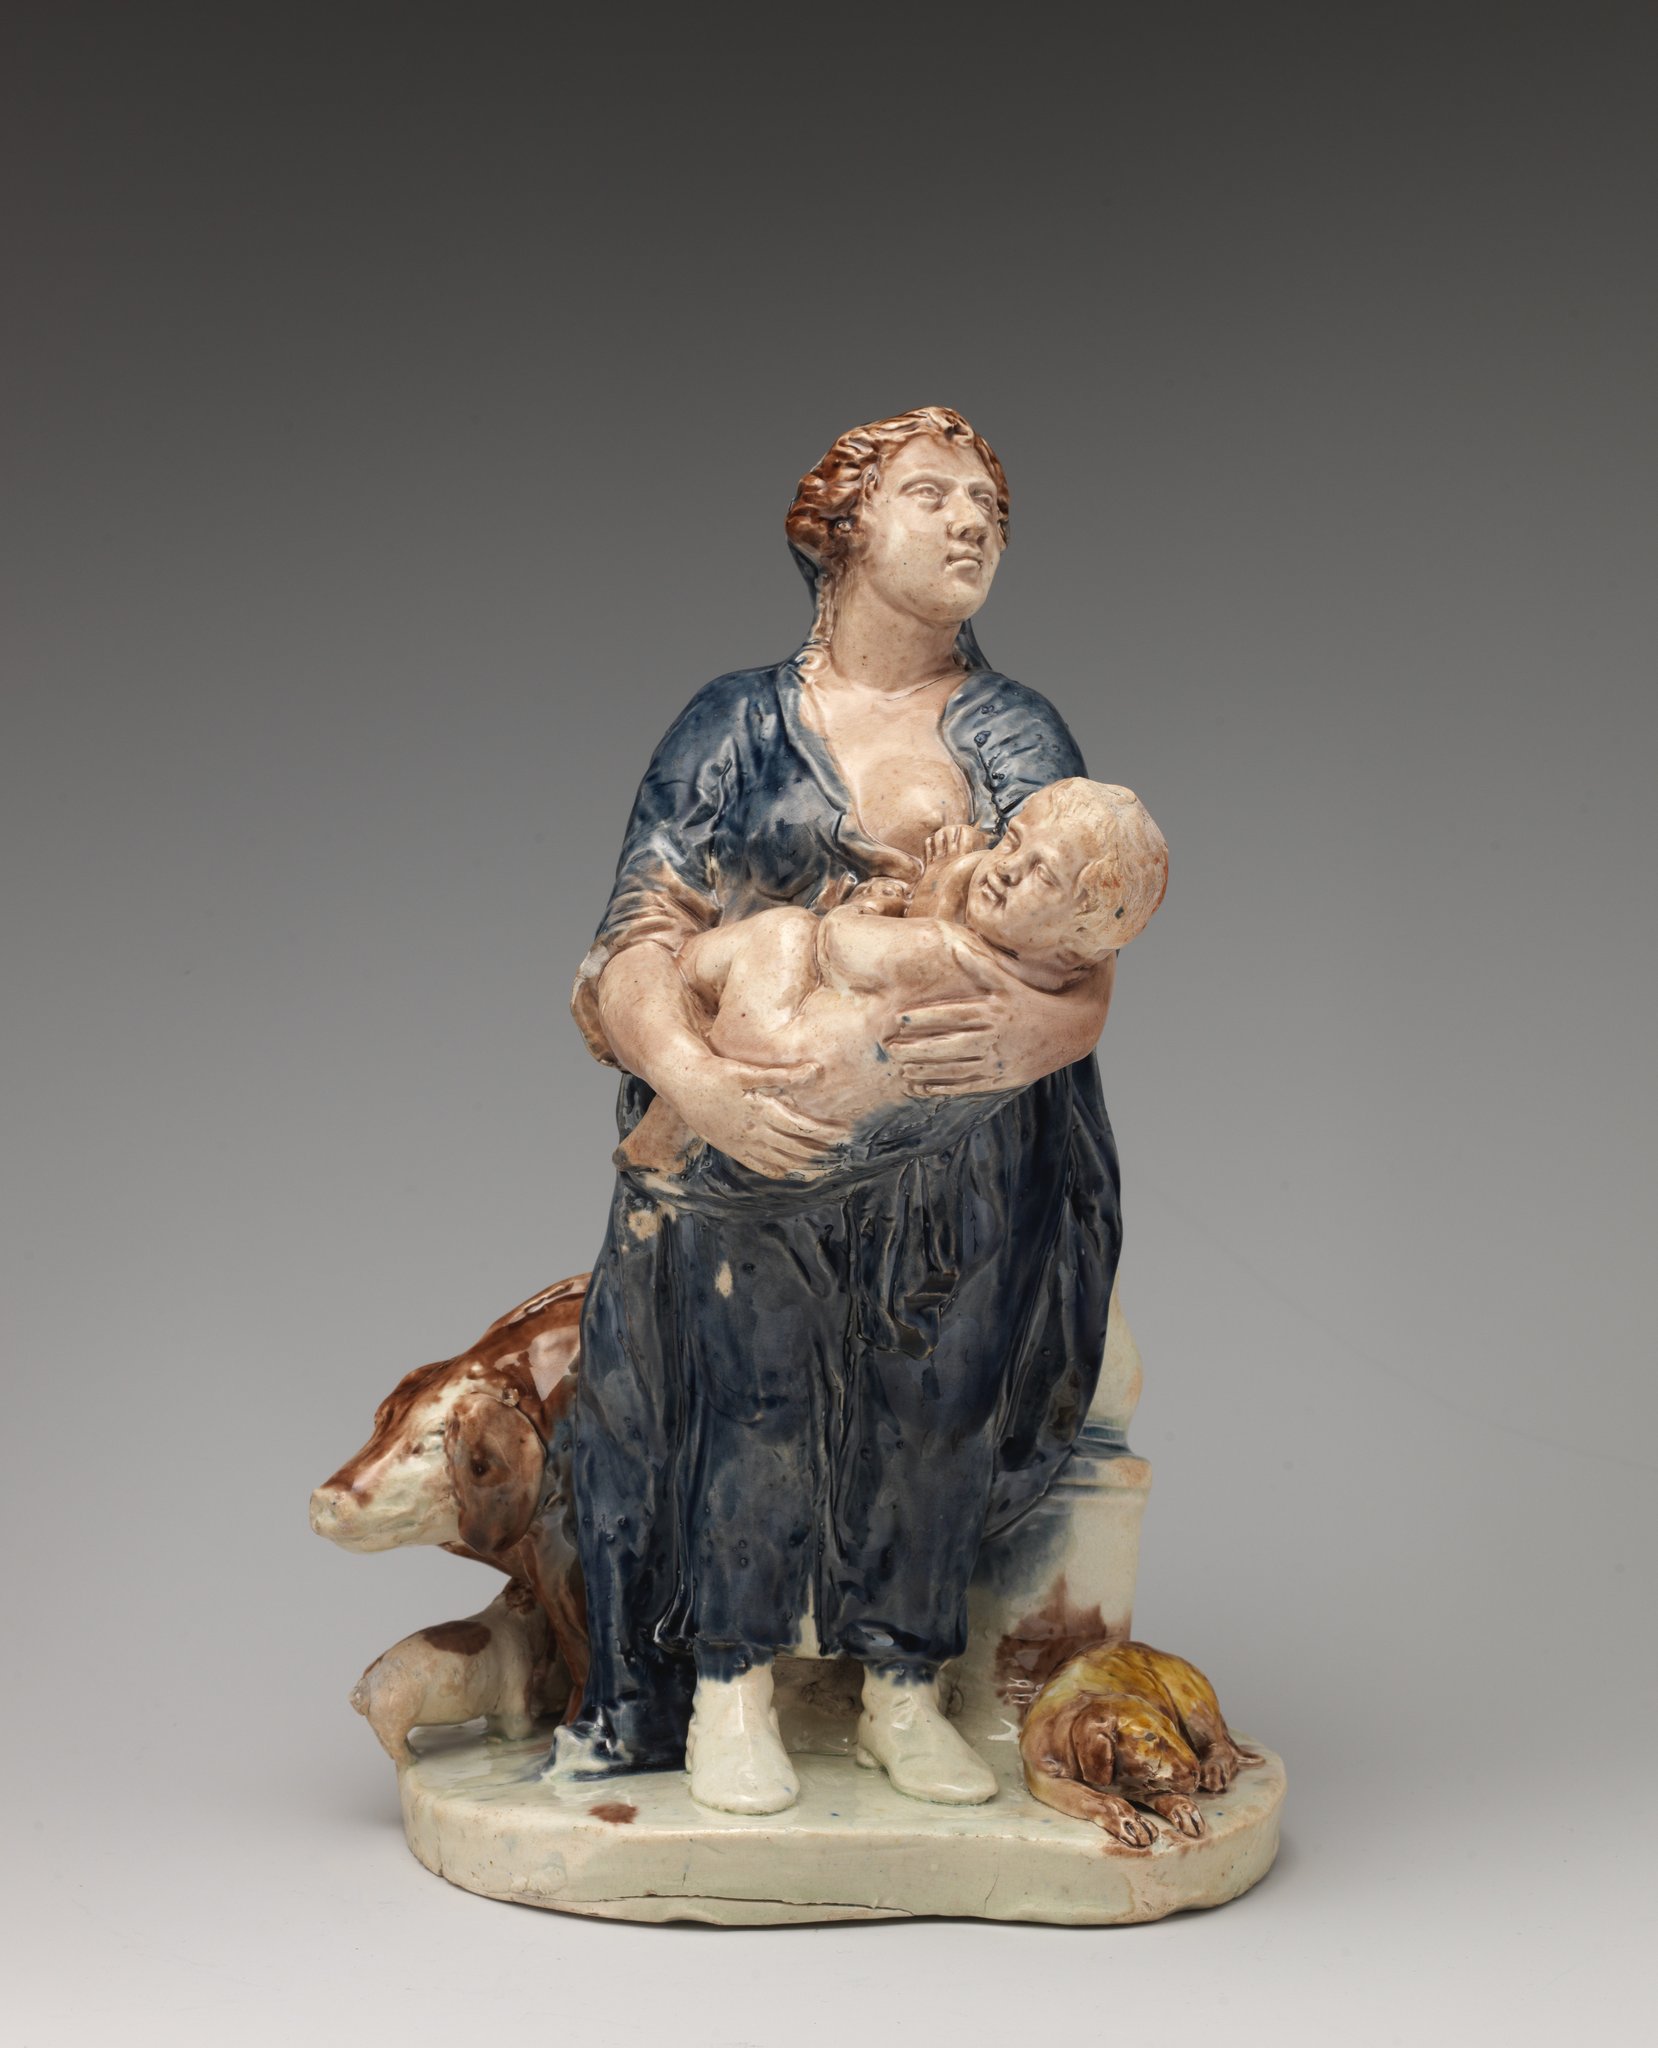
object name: figure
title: The Farmer's Wife (part of a "Tithe Pig" group)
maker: ralph wood the younger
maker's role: maker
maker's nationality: british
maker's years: 1748-1795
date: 1770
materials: earthenware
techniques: glazing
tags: children,women,dogs,pigs